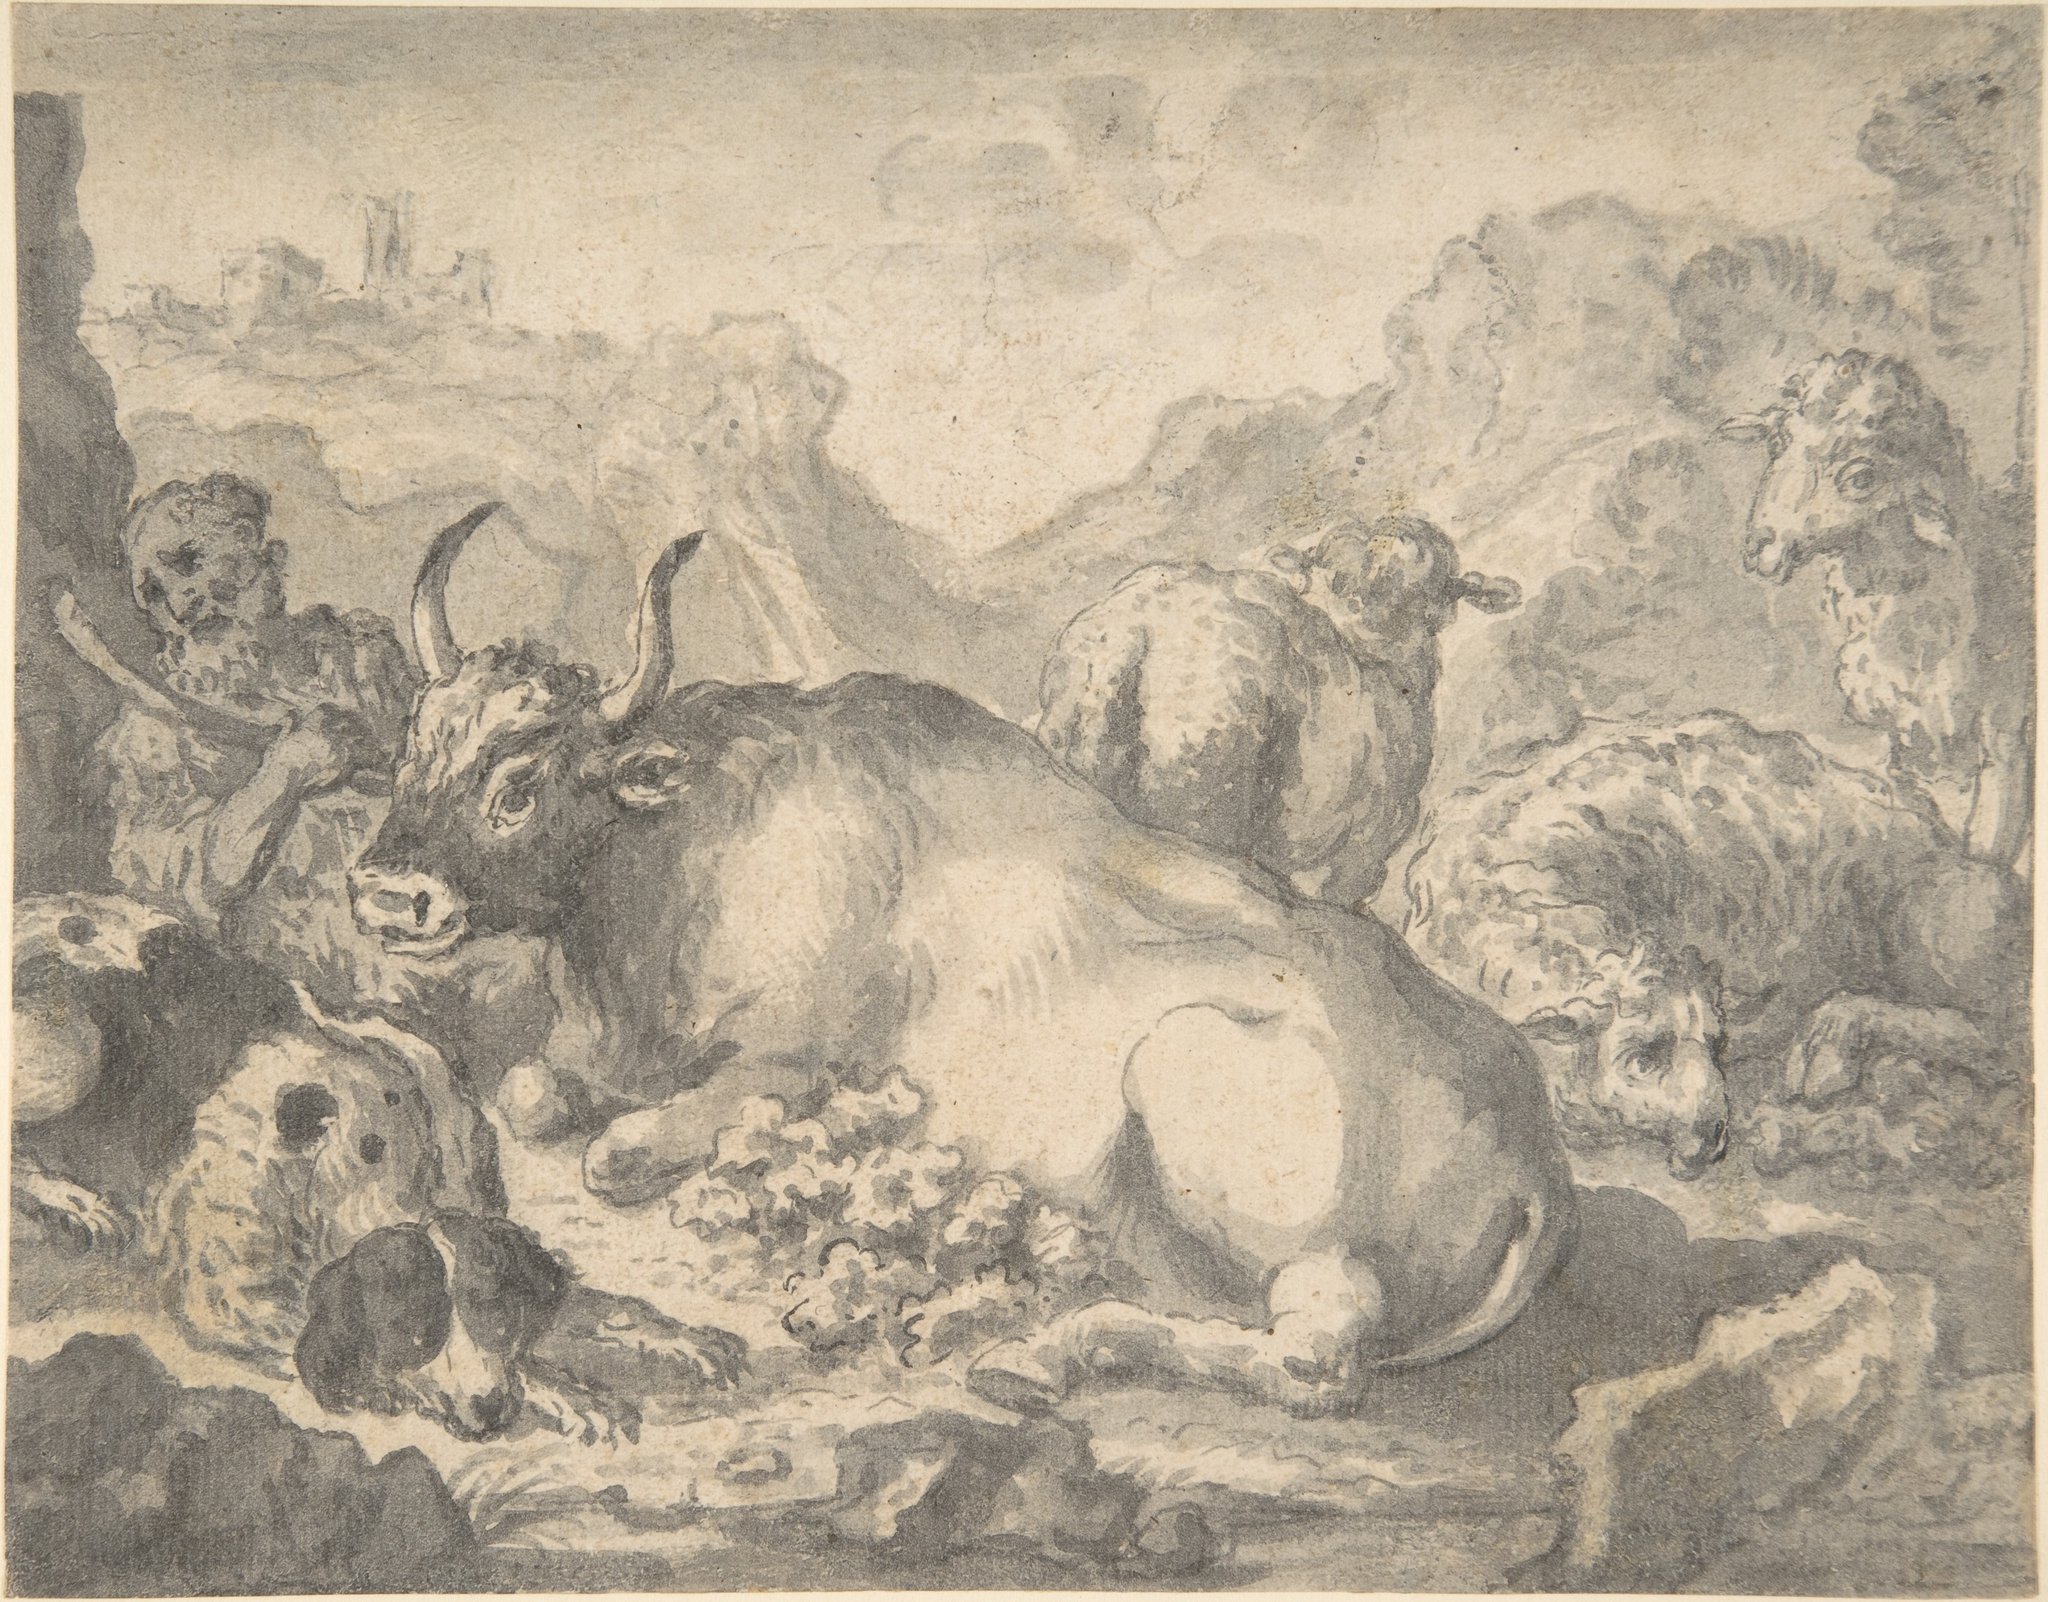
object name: drawing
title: Sheperd with his Flock and a Dog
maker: anonymous, flemish, 17th century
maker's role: artist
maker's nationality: flemish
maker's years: 1600-1700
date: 1501-1600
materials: chalk, ink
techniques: brush, pen, wash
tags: cows,dogs,sheep,shepherds